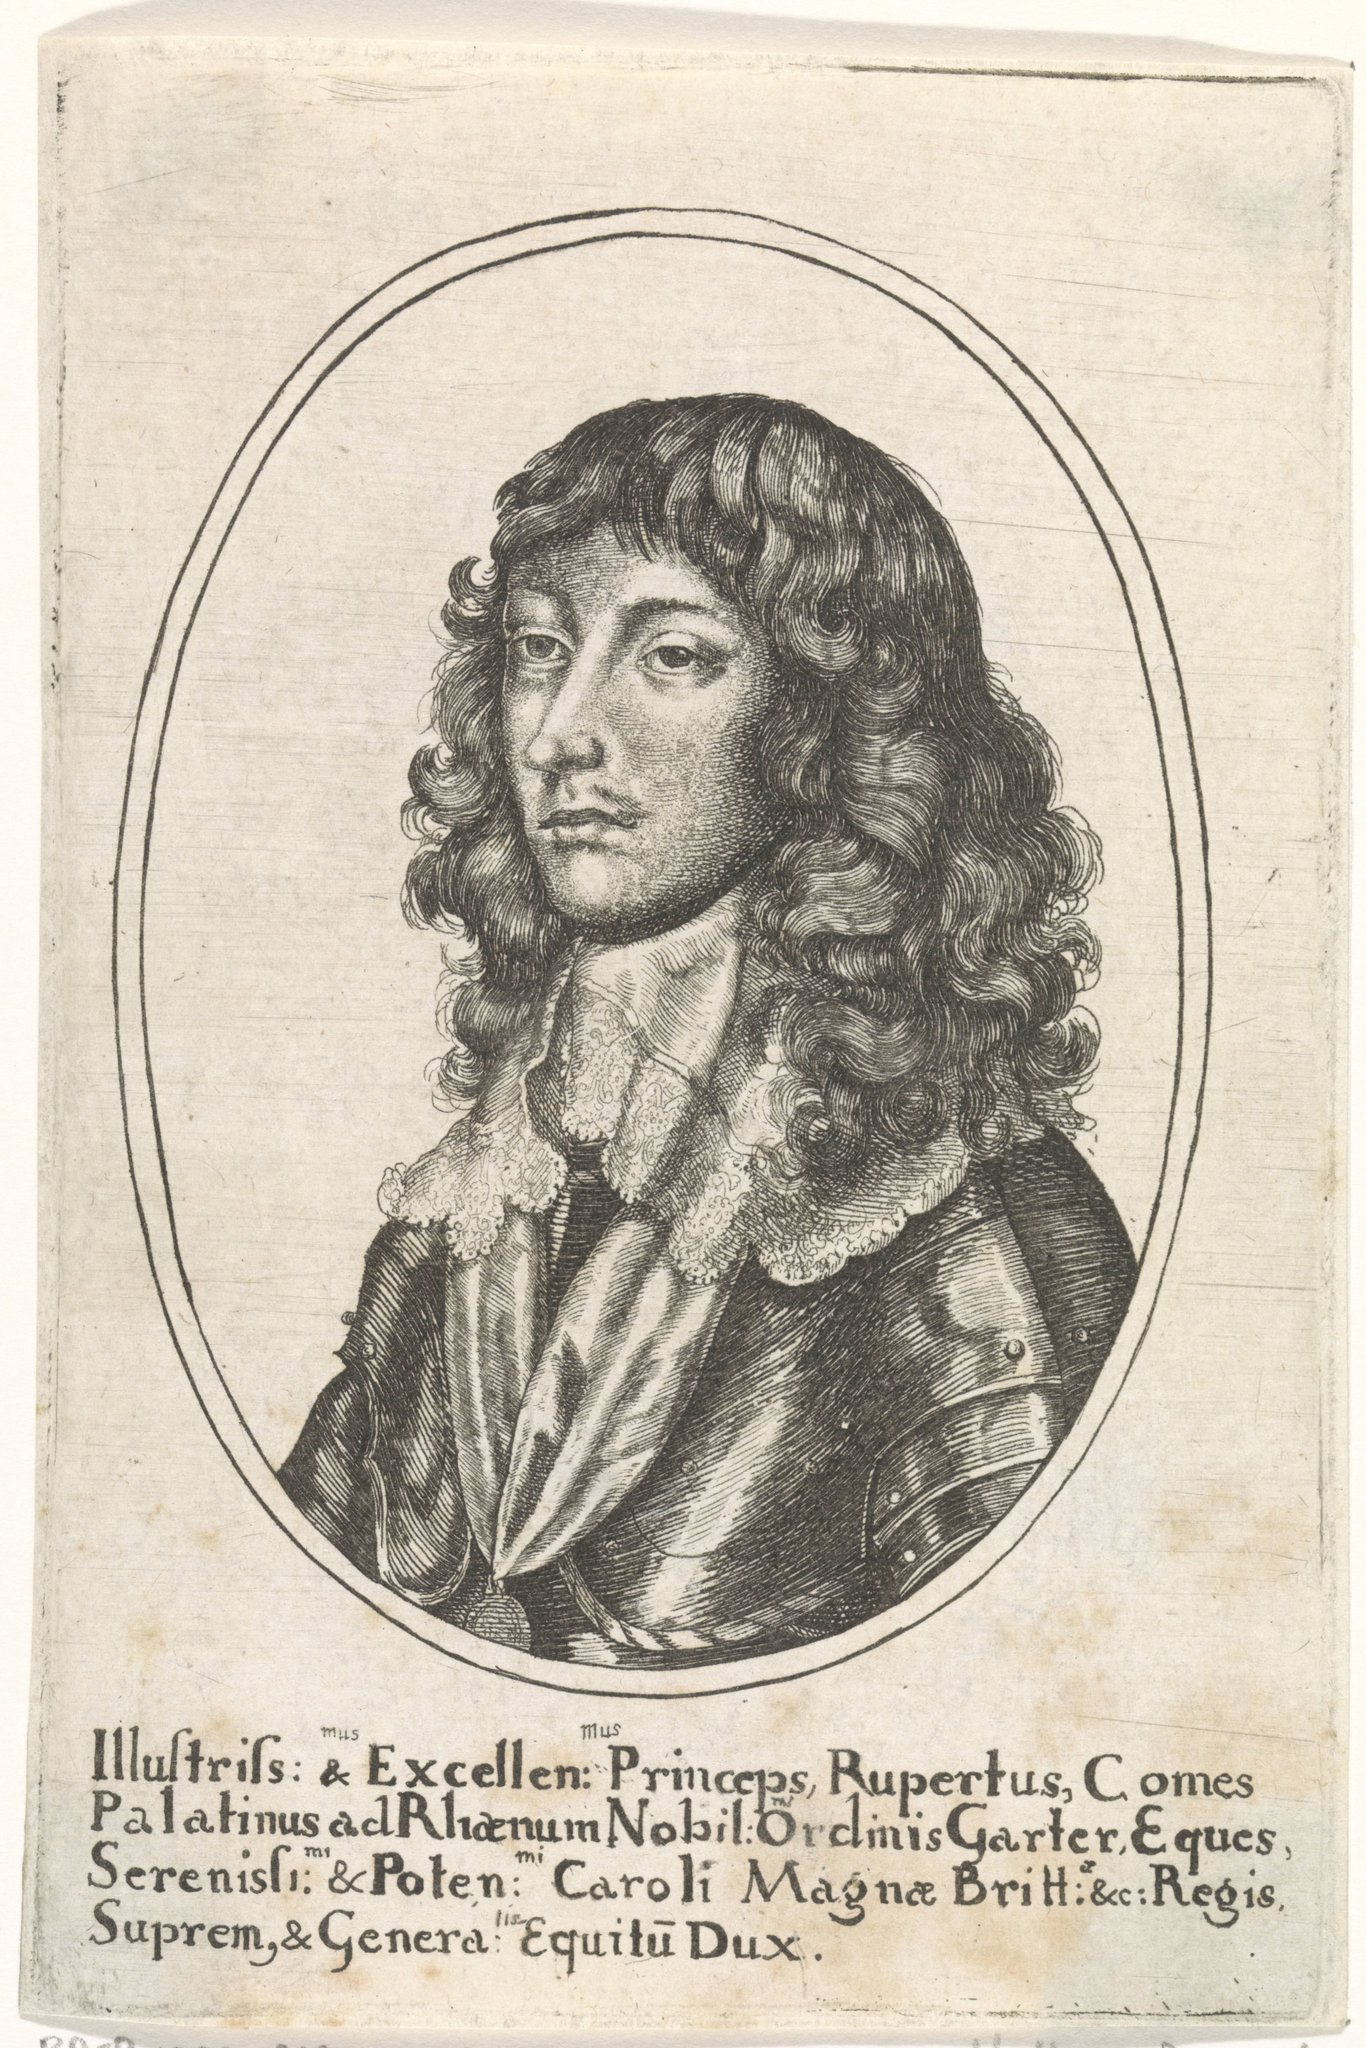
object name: print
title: Portret van Prins Ruprecht van de Palts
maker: Anonymous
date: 1643-1727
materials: paper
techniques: etching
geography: england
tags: prague, london, painter, print maker, draughtsman, prinz ruprecht, styles of hairdress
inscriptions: collector's mark: Lugt 2228, collector's mark: Lugt 2760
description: Prins Ruprecht van de Palts, neef van koning Karel I van Engeland en commandant van de royalistische cavalerie tijdens de Engelse Burgeroorlog